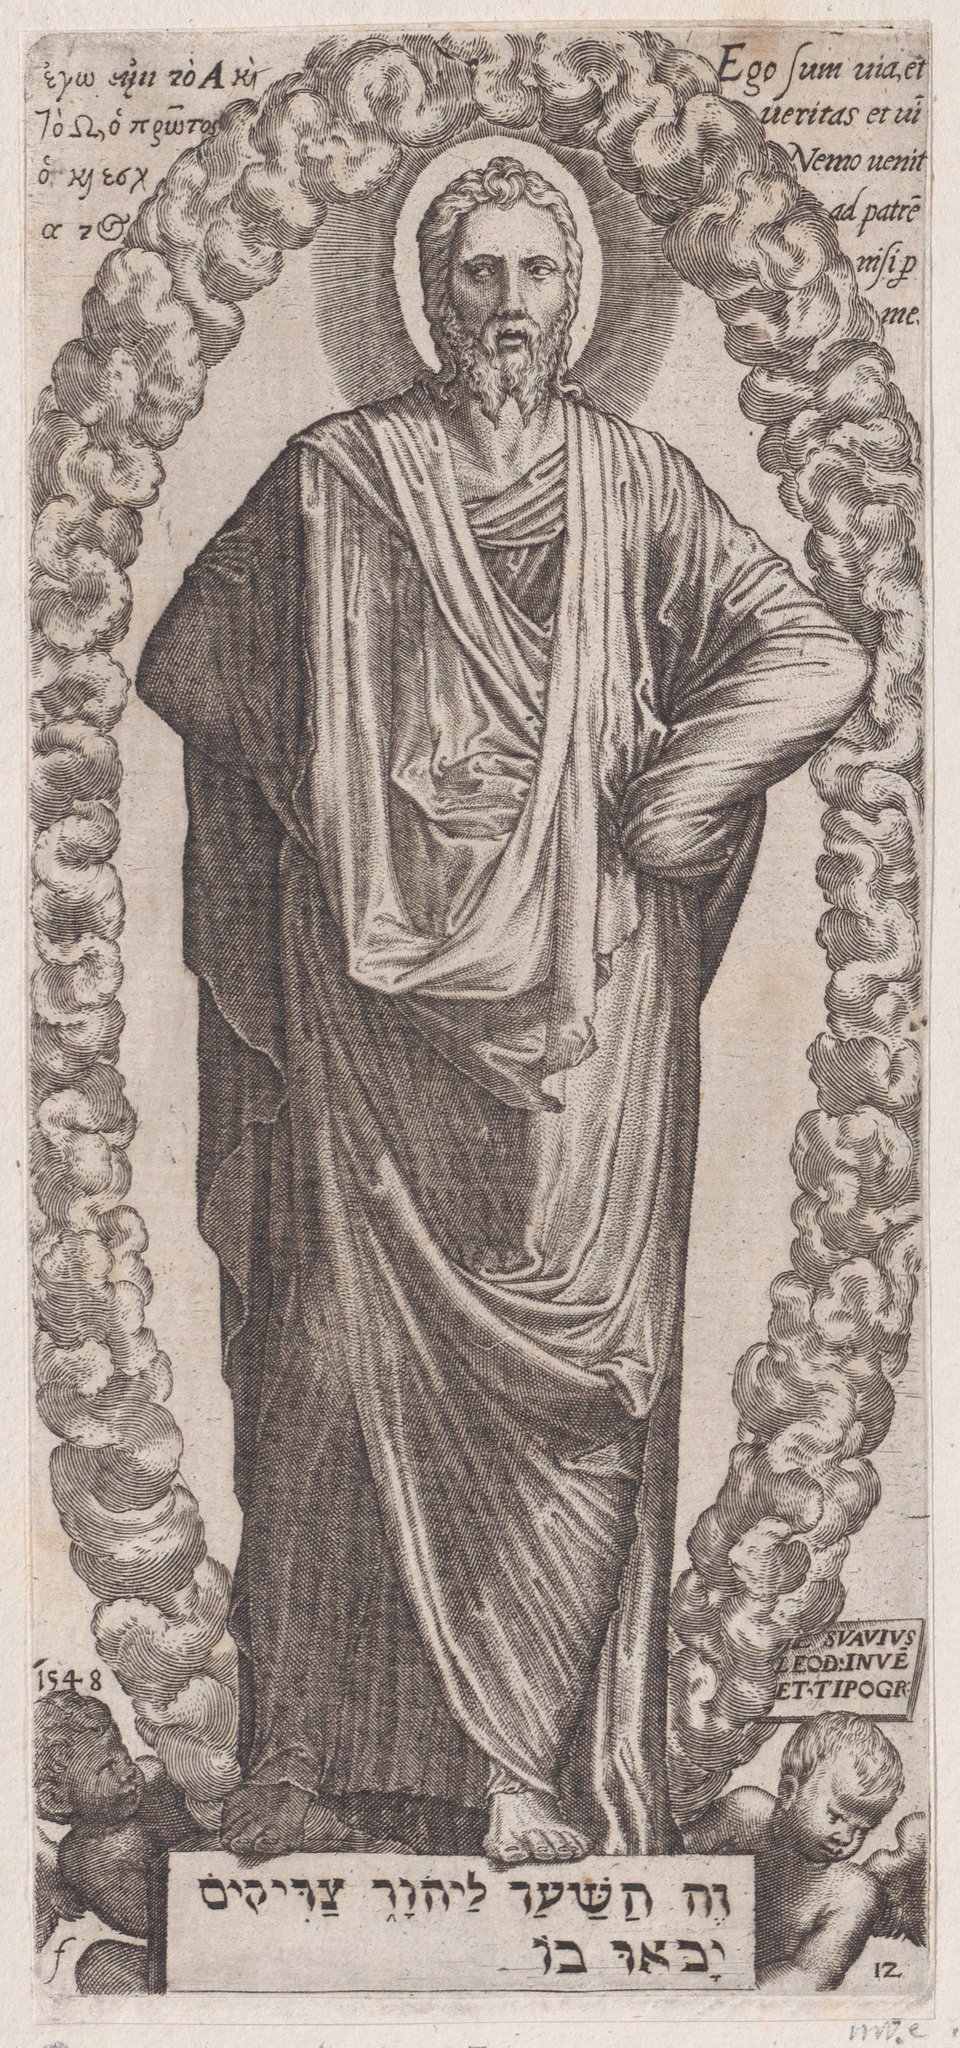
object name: print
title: Christ, from "Christ, the Twelve Apostles and St. Paul"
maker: lambert suavius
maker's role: artist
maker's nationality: netherlandish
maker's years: 1510-1576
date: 1525-1576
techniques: engraving